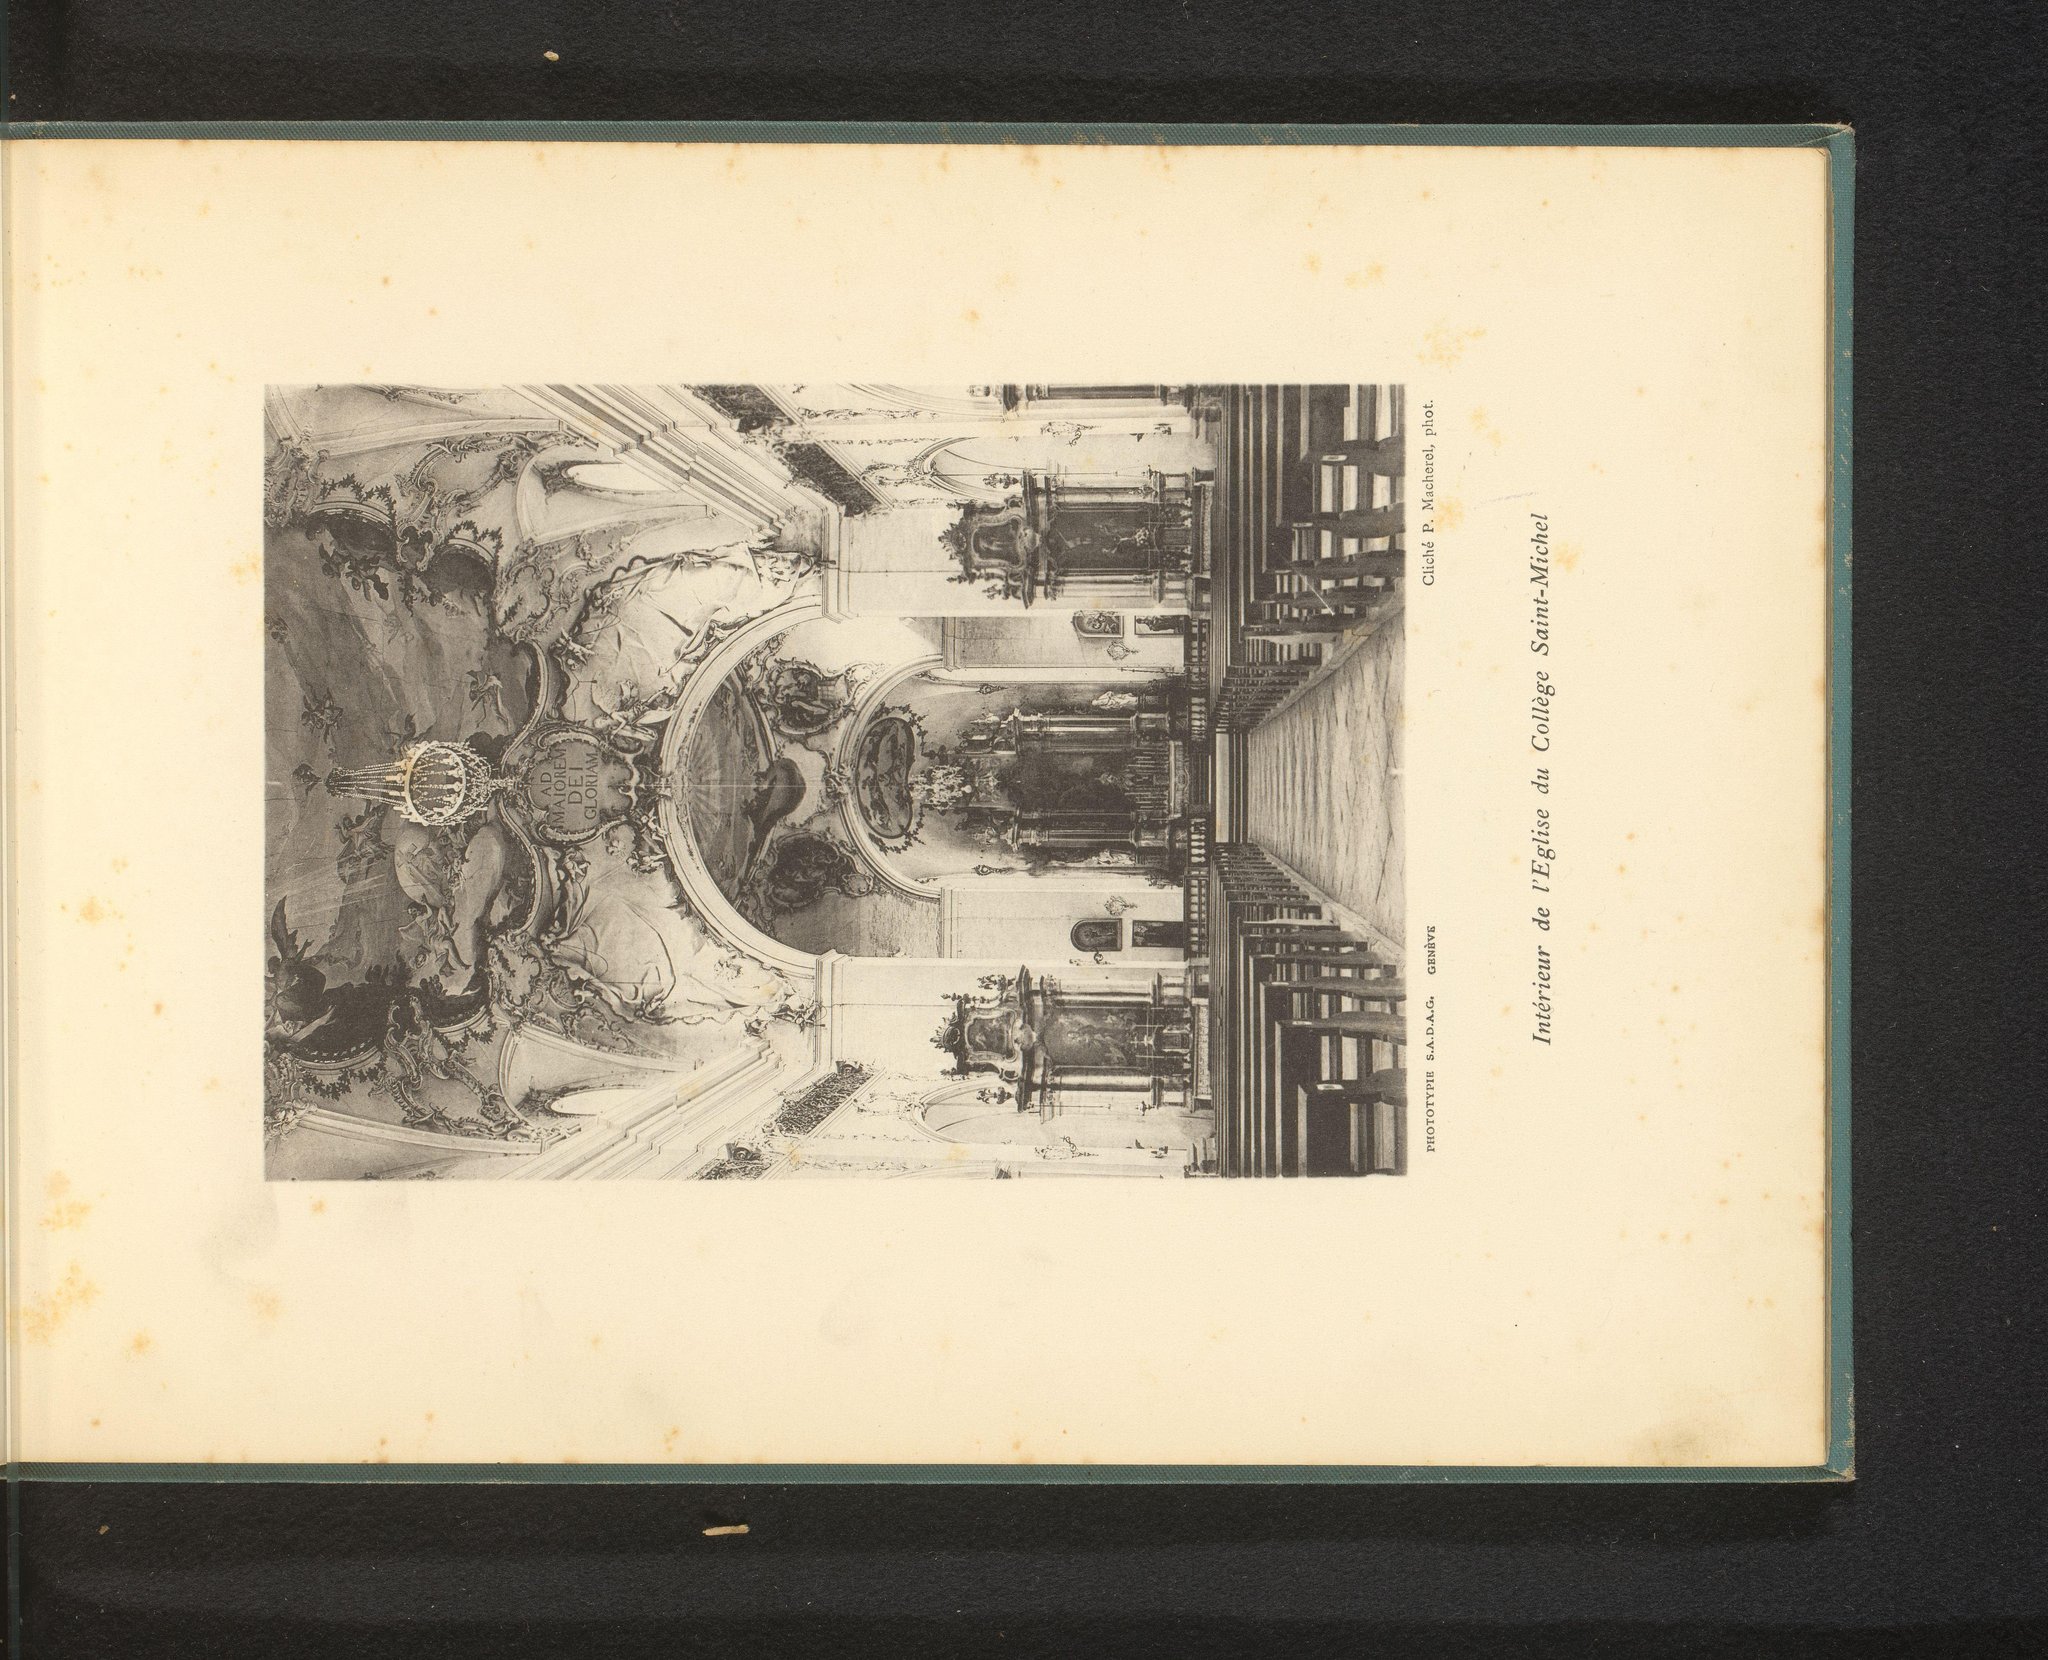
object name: page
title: Intérieur de l'Eglise du Collège Saint-Michel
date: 1897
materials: paper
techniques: photograph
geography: fribourg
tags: interior of church, university building, college